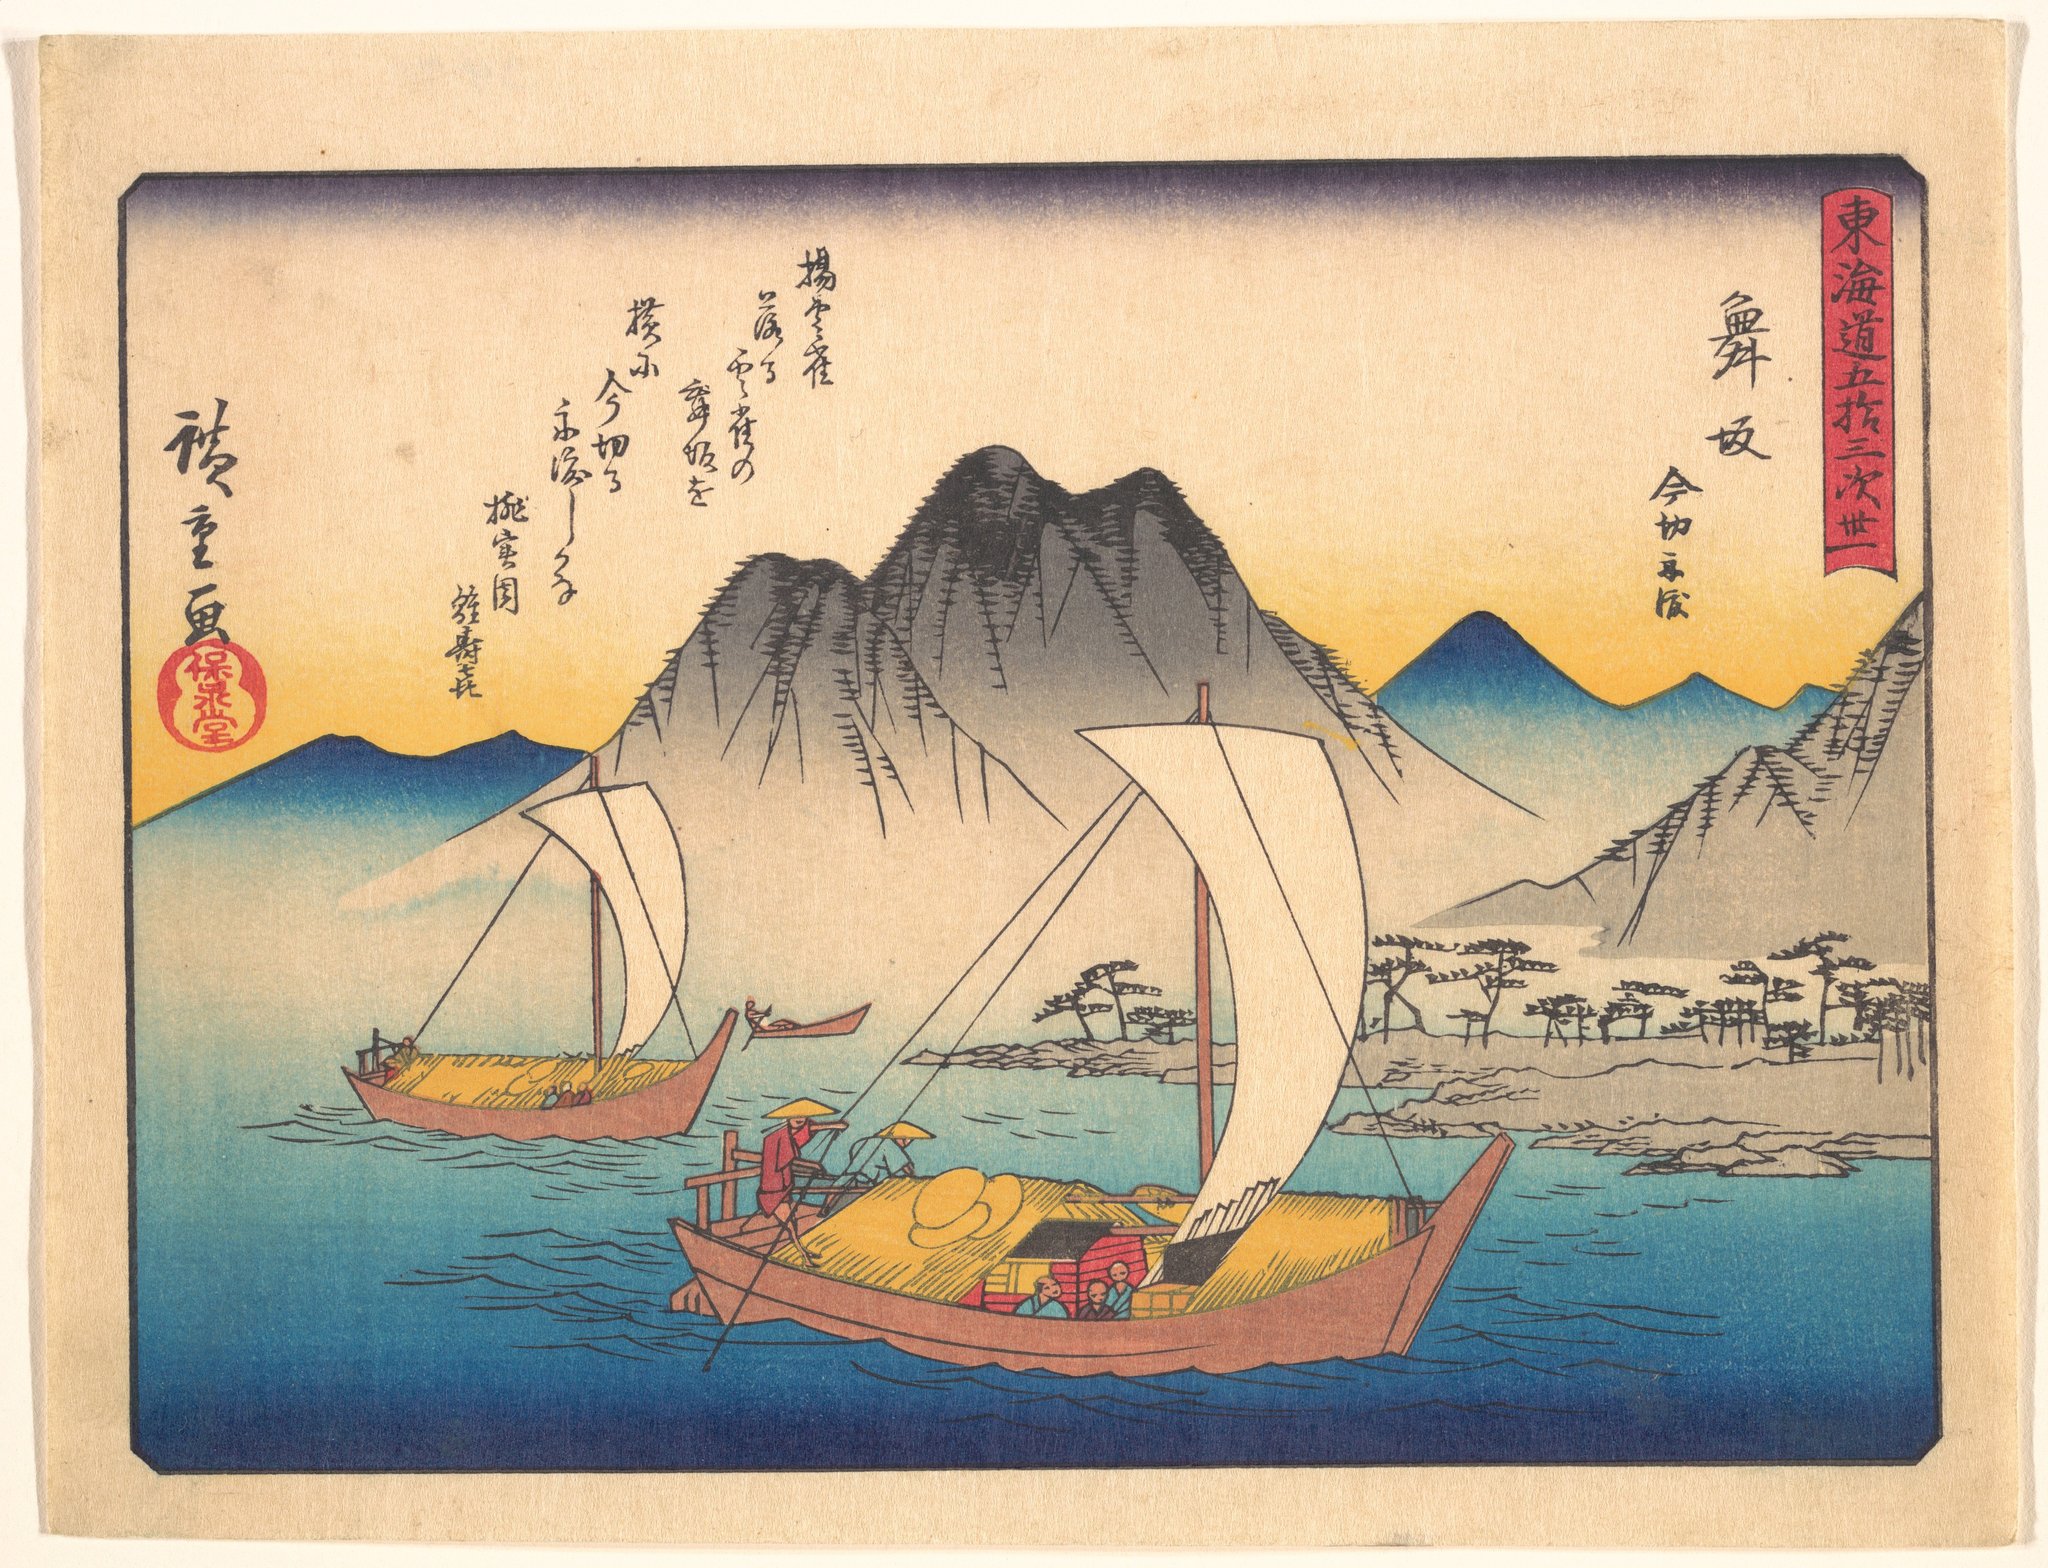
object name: print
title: 東海道五十三次 舞坂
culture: japanese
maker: utagawa hiroshige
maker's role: artist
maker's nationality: japanese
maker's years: 1797-1858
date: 1901-1933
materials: ink, paper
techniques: woodblock print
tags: mountains,boats